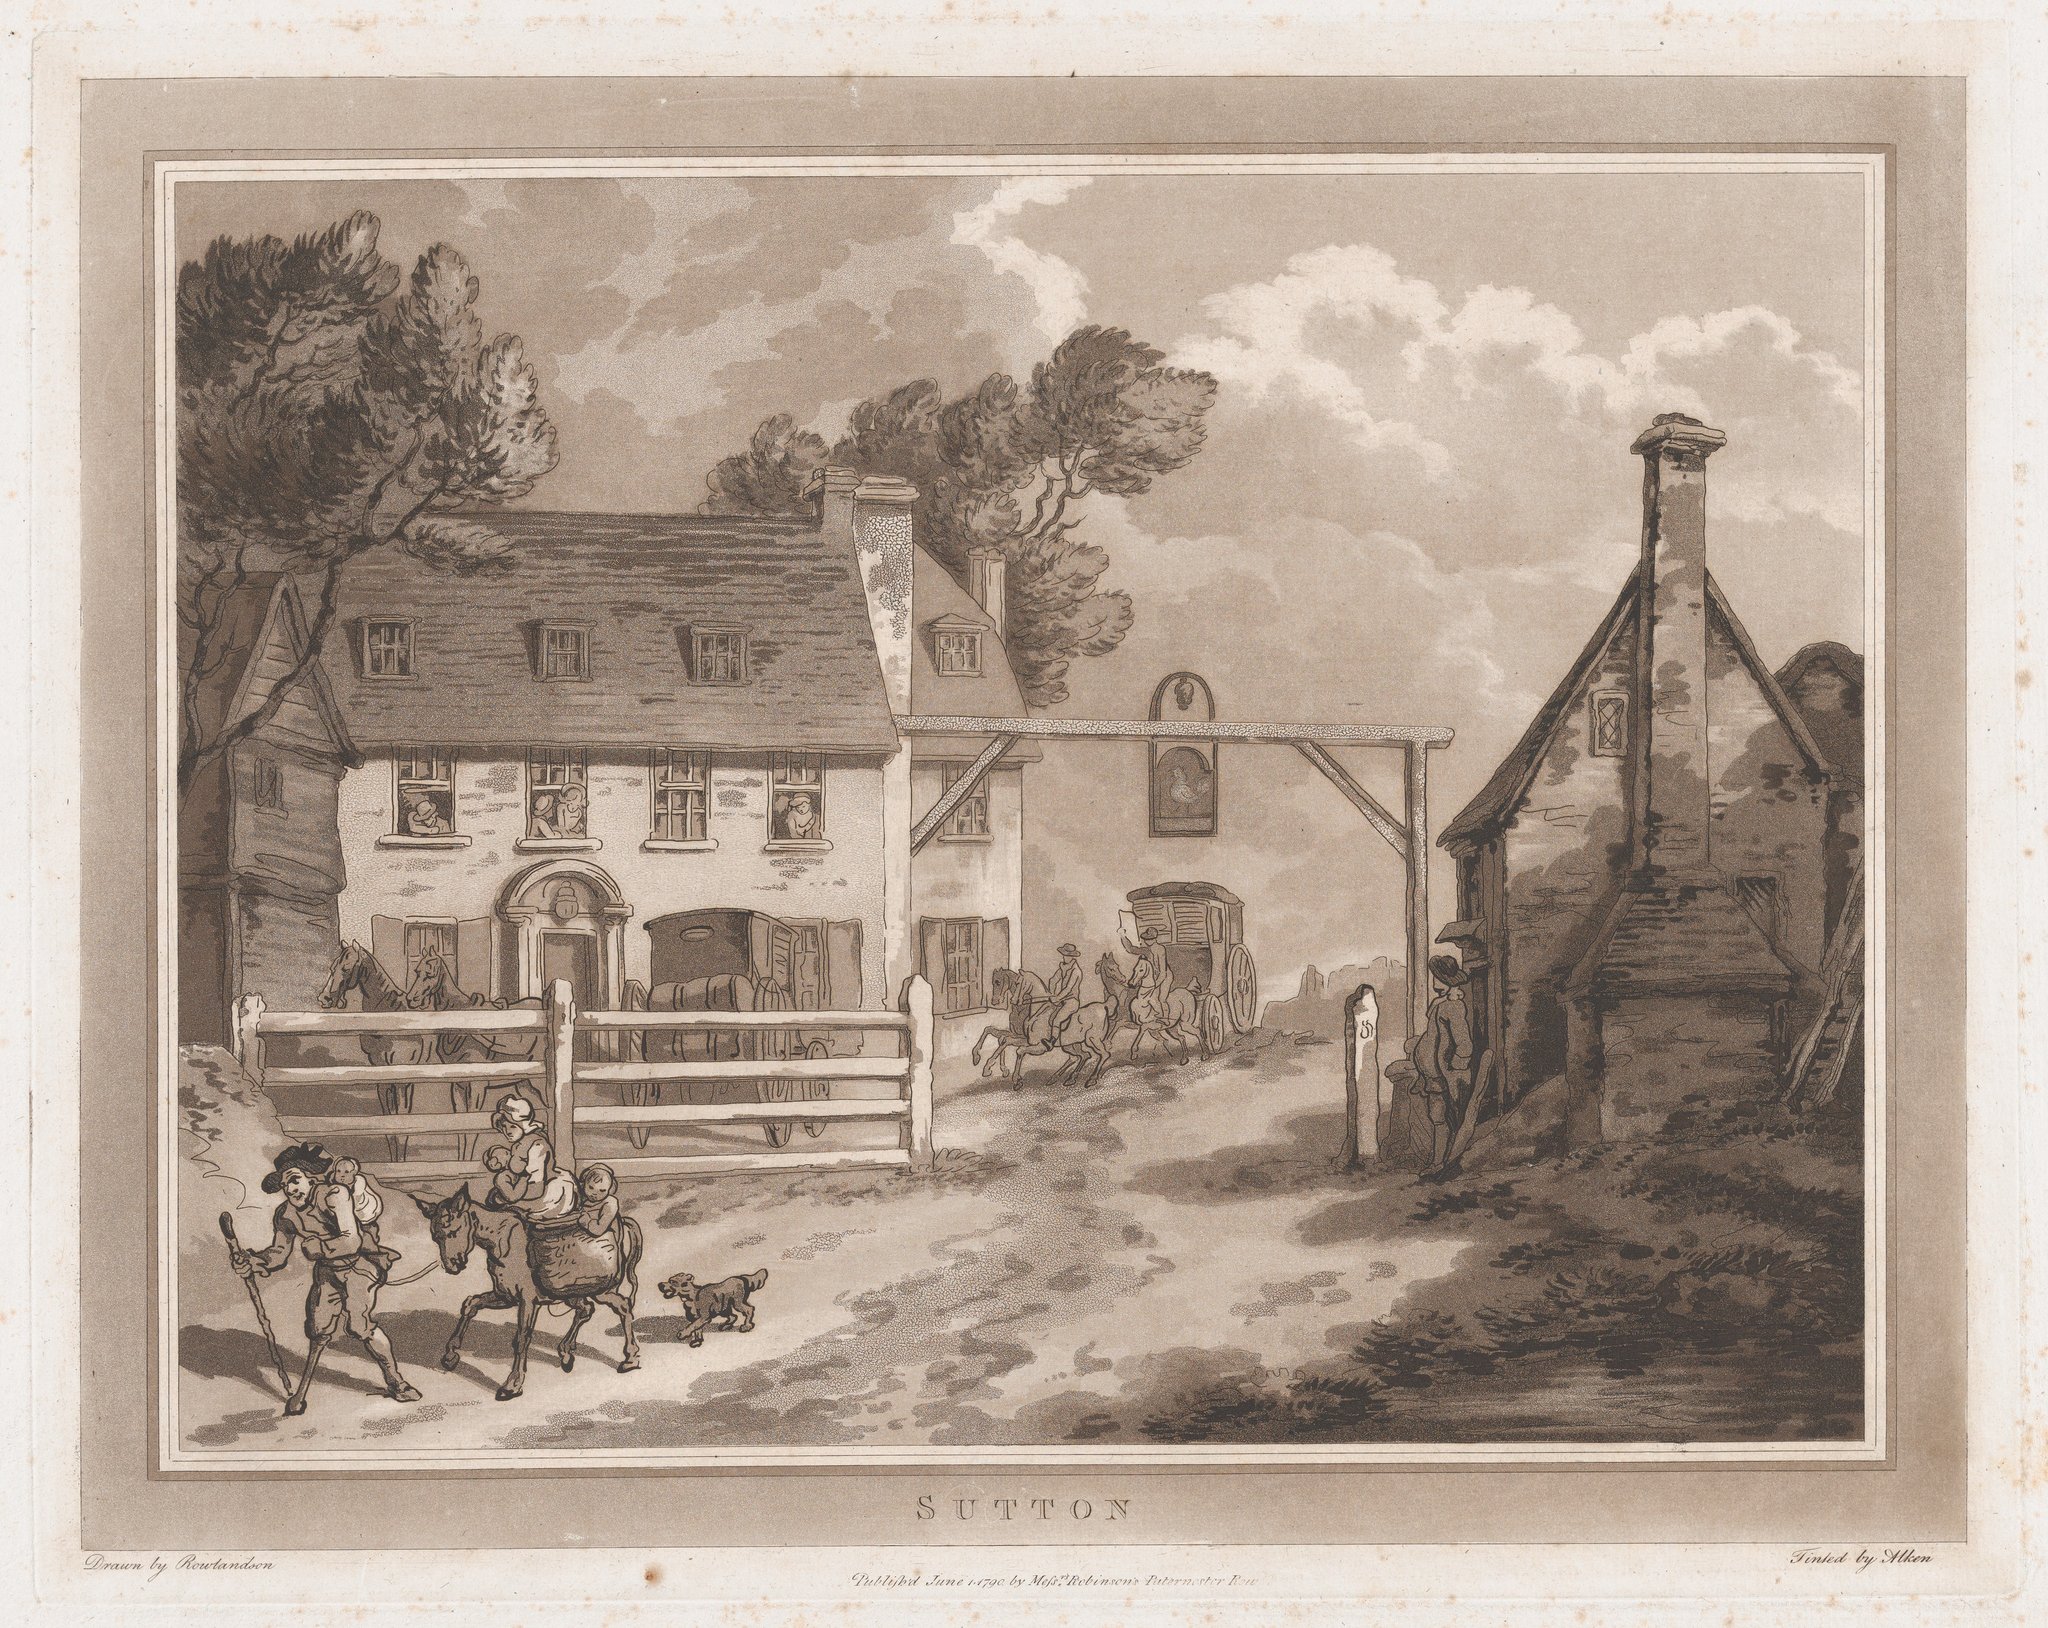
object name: print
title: Sutton (An Excursion to Brighthelmstone)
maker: thomas rowlandson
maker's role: artist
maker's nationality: british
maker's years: 1757-1827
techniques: aquatint, etching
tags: houses,towns,men,horses,carriages